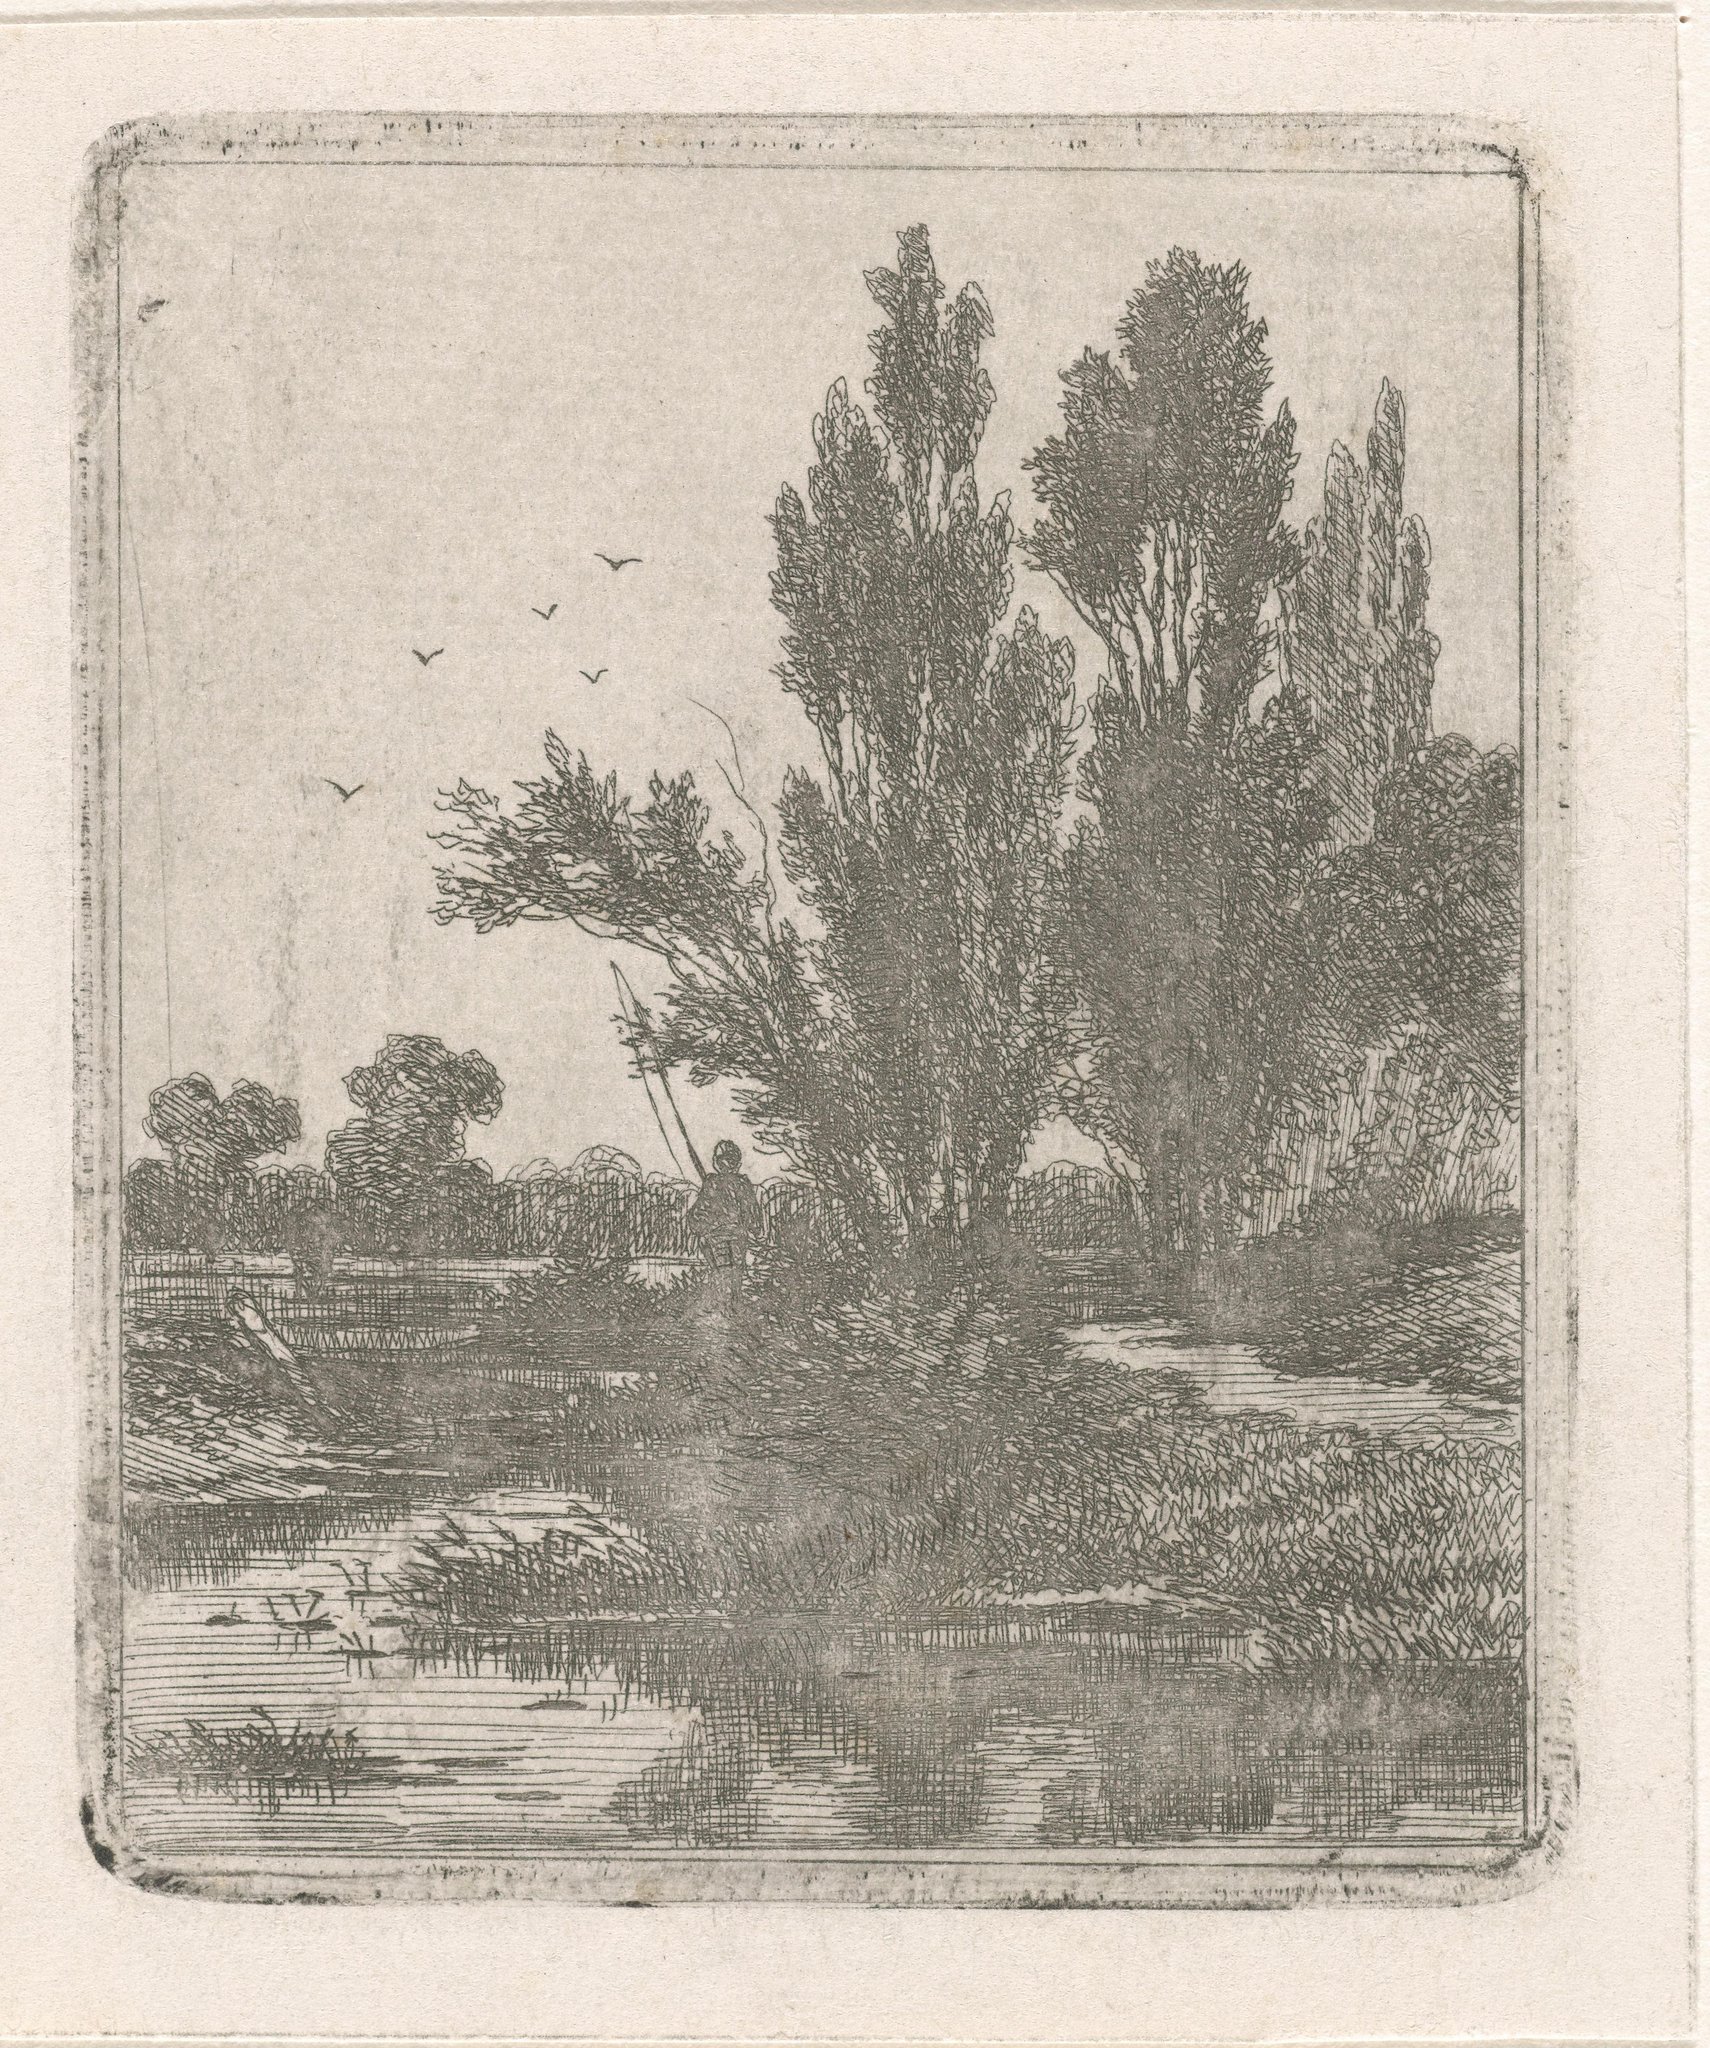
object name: print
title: Rivierlandschap met hengelaar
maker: jan van lokhorst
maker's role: draughtsman, print maker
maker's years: 1837-1894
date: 1847-1874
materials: paper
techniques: etching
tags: landscapes with waters, waterscapes, seascapes (in the temperate zone), fisherman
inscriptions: collector's mark: Lugt 2228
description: Rivierlandschap met een hengelaar op de oever.